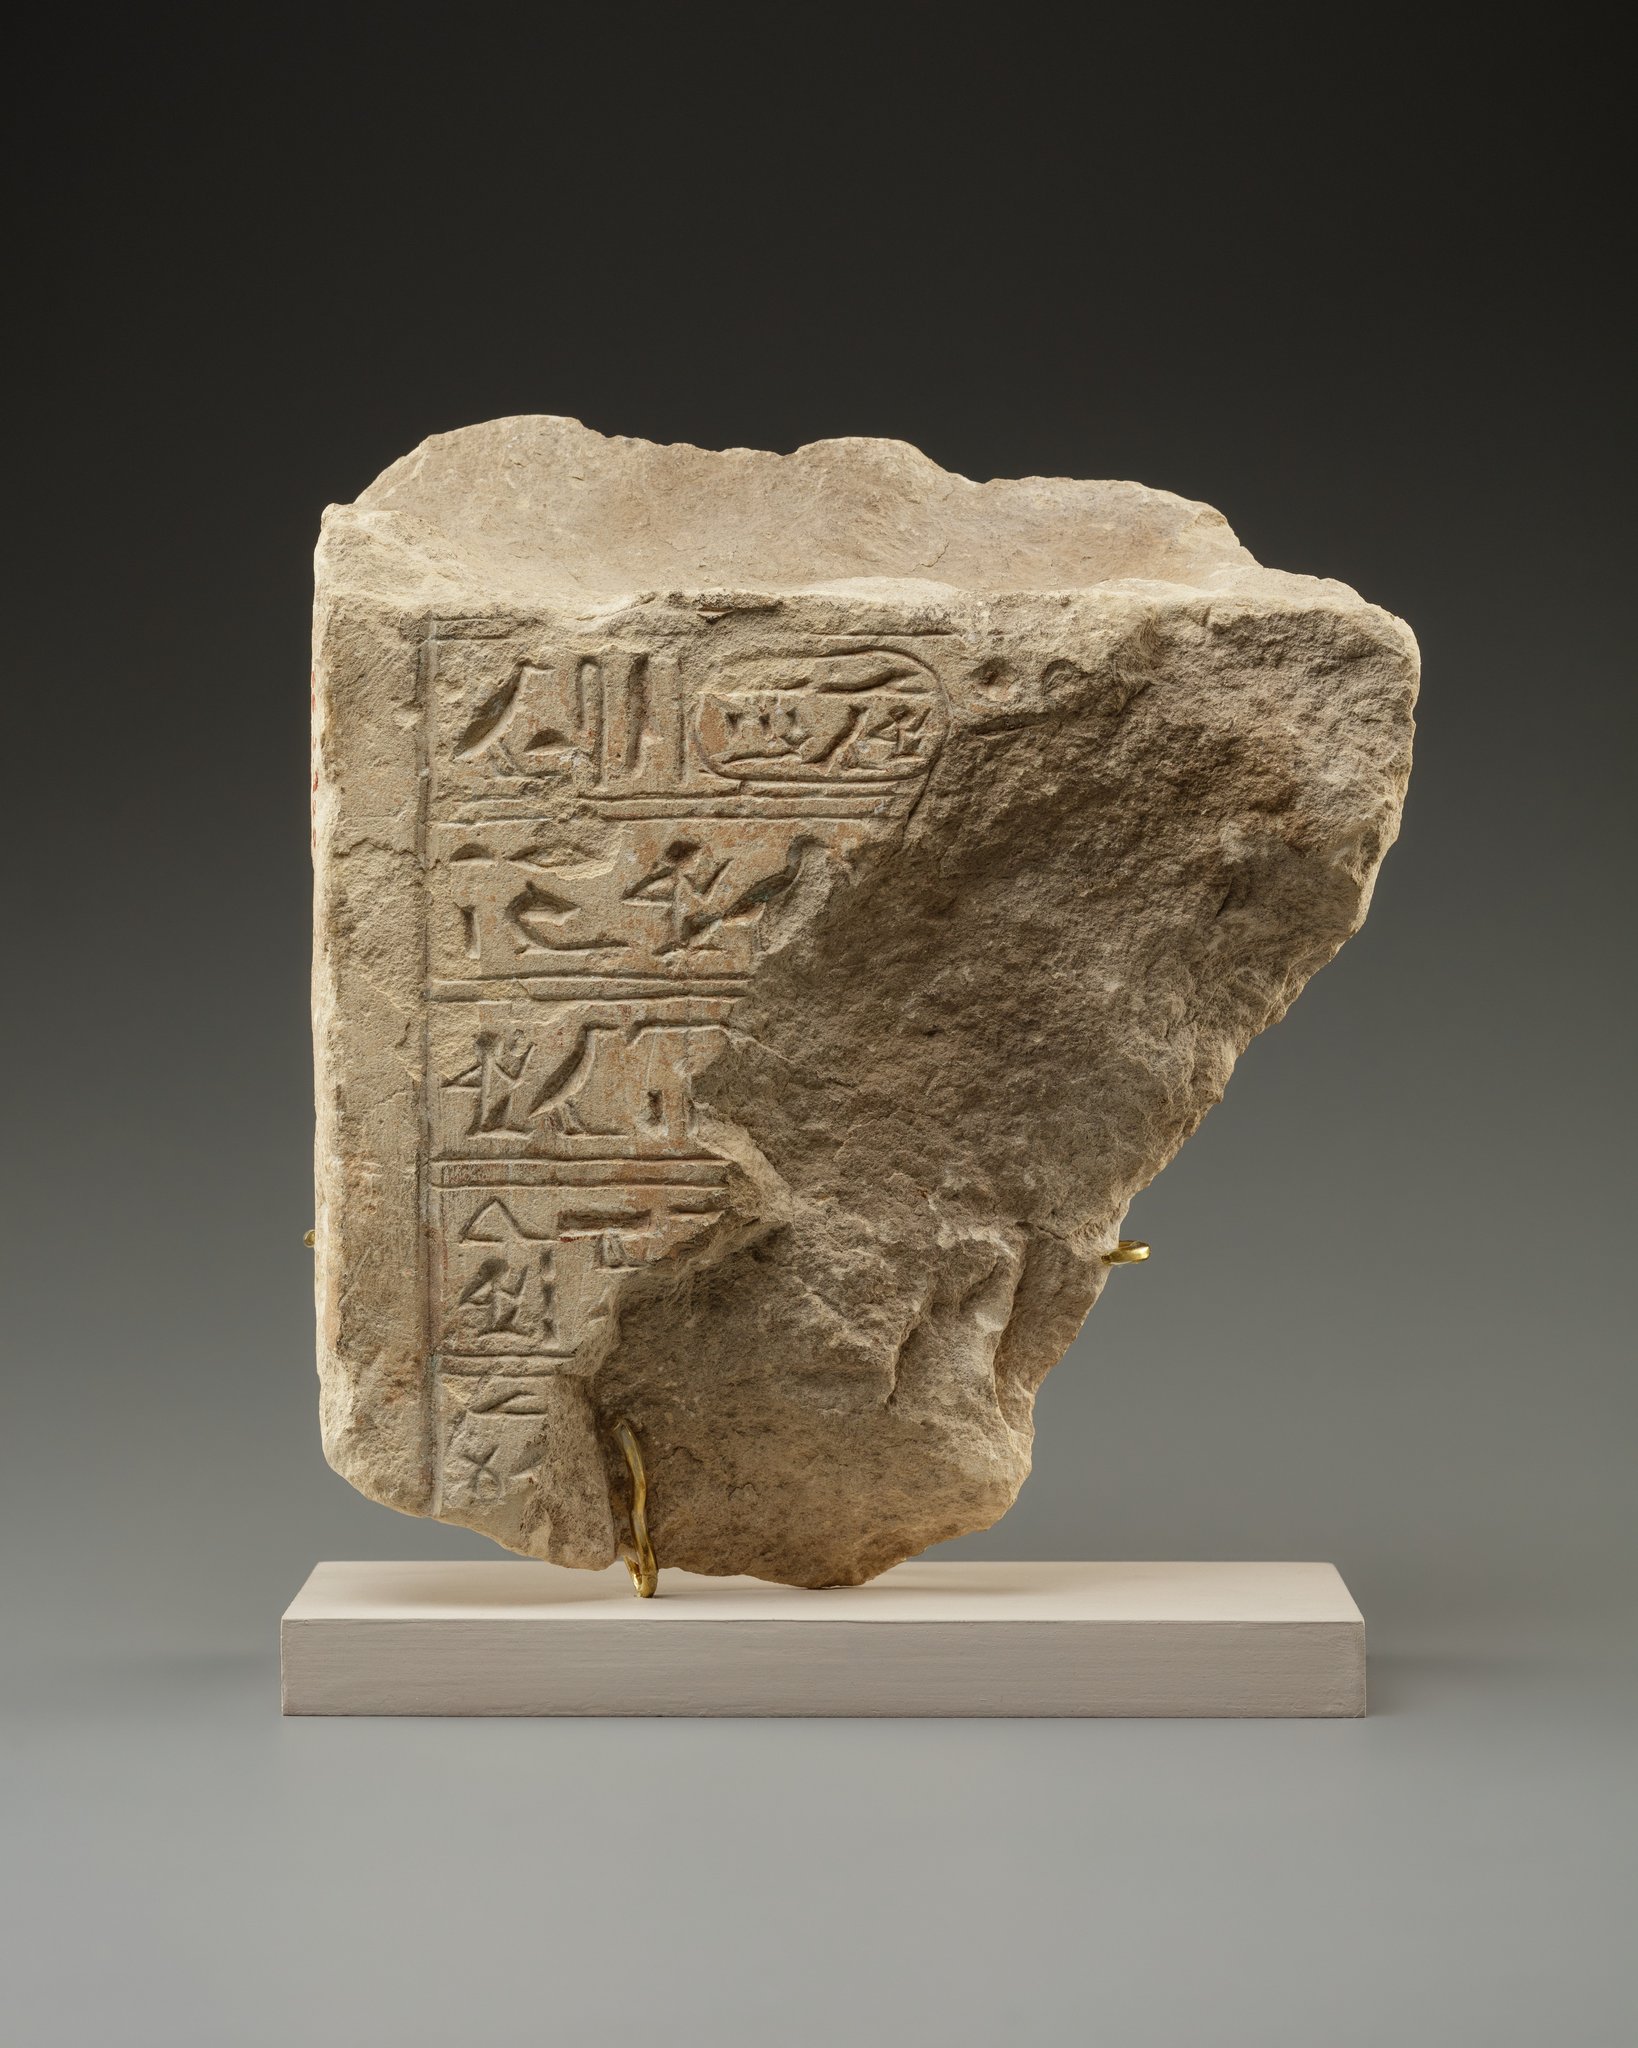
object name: stela fragment, sebekemsaf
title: Stela fragment of Sebekemsaf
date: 1564-1557 BCE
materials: limestone